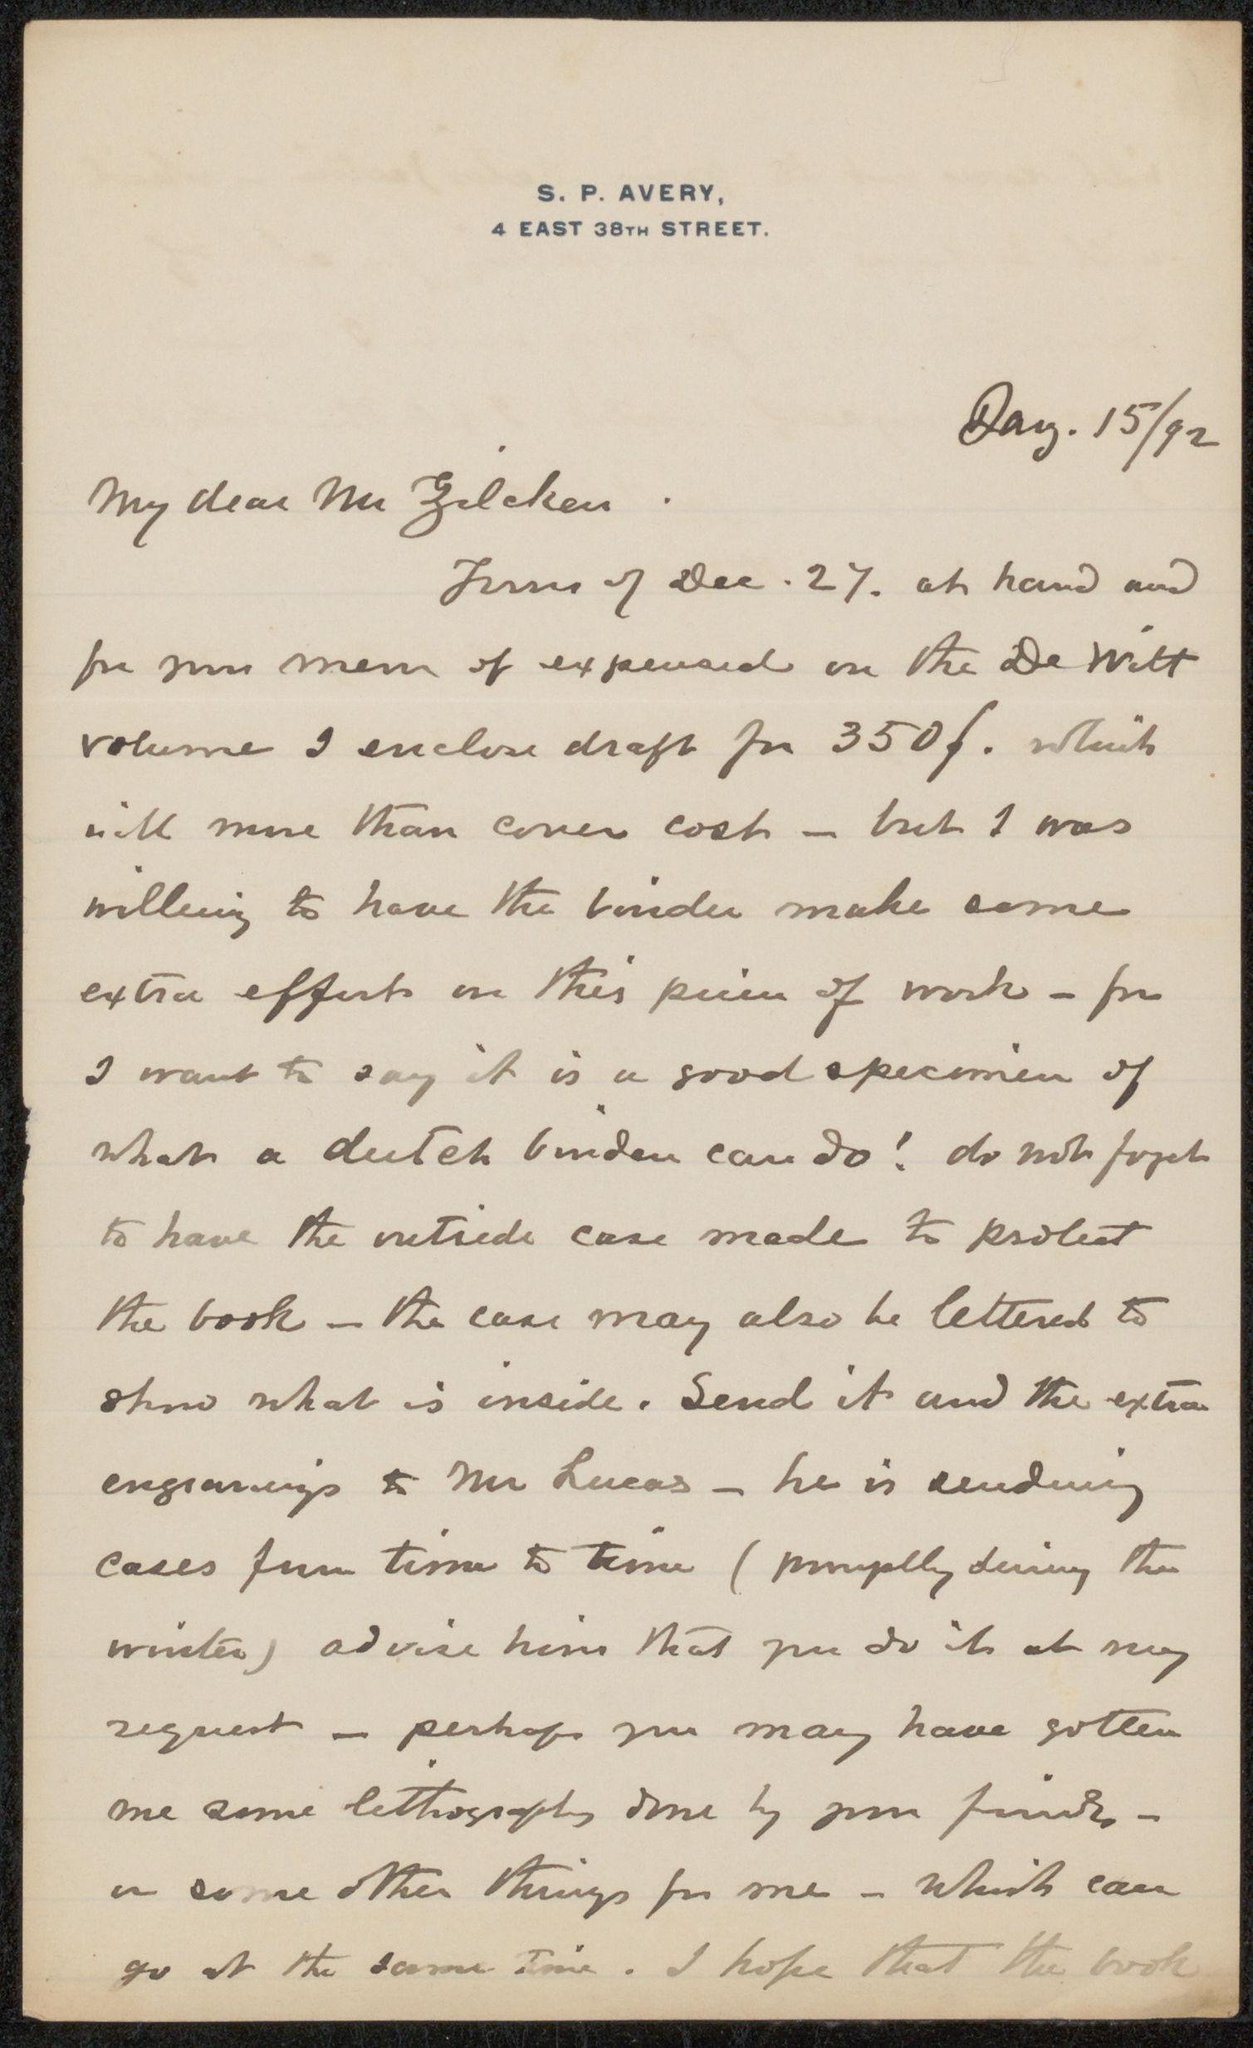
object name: letter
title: Brief aan Philip Zilcken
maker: samuel putnam avery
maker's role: verzamelaar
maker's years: 1822-1904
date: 1892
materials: ink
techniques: pen, printing, writing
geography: new york city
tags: painter, draughtsman, philip zilcken, temporary exhibition, 'salon', money, printed matter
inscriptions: collector's mark: ‘RPK’